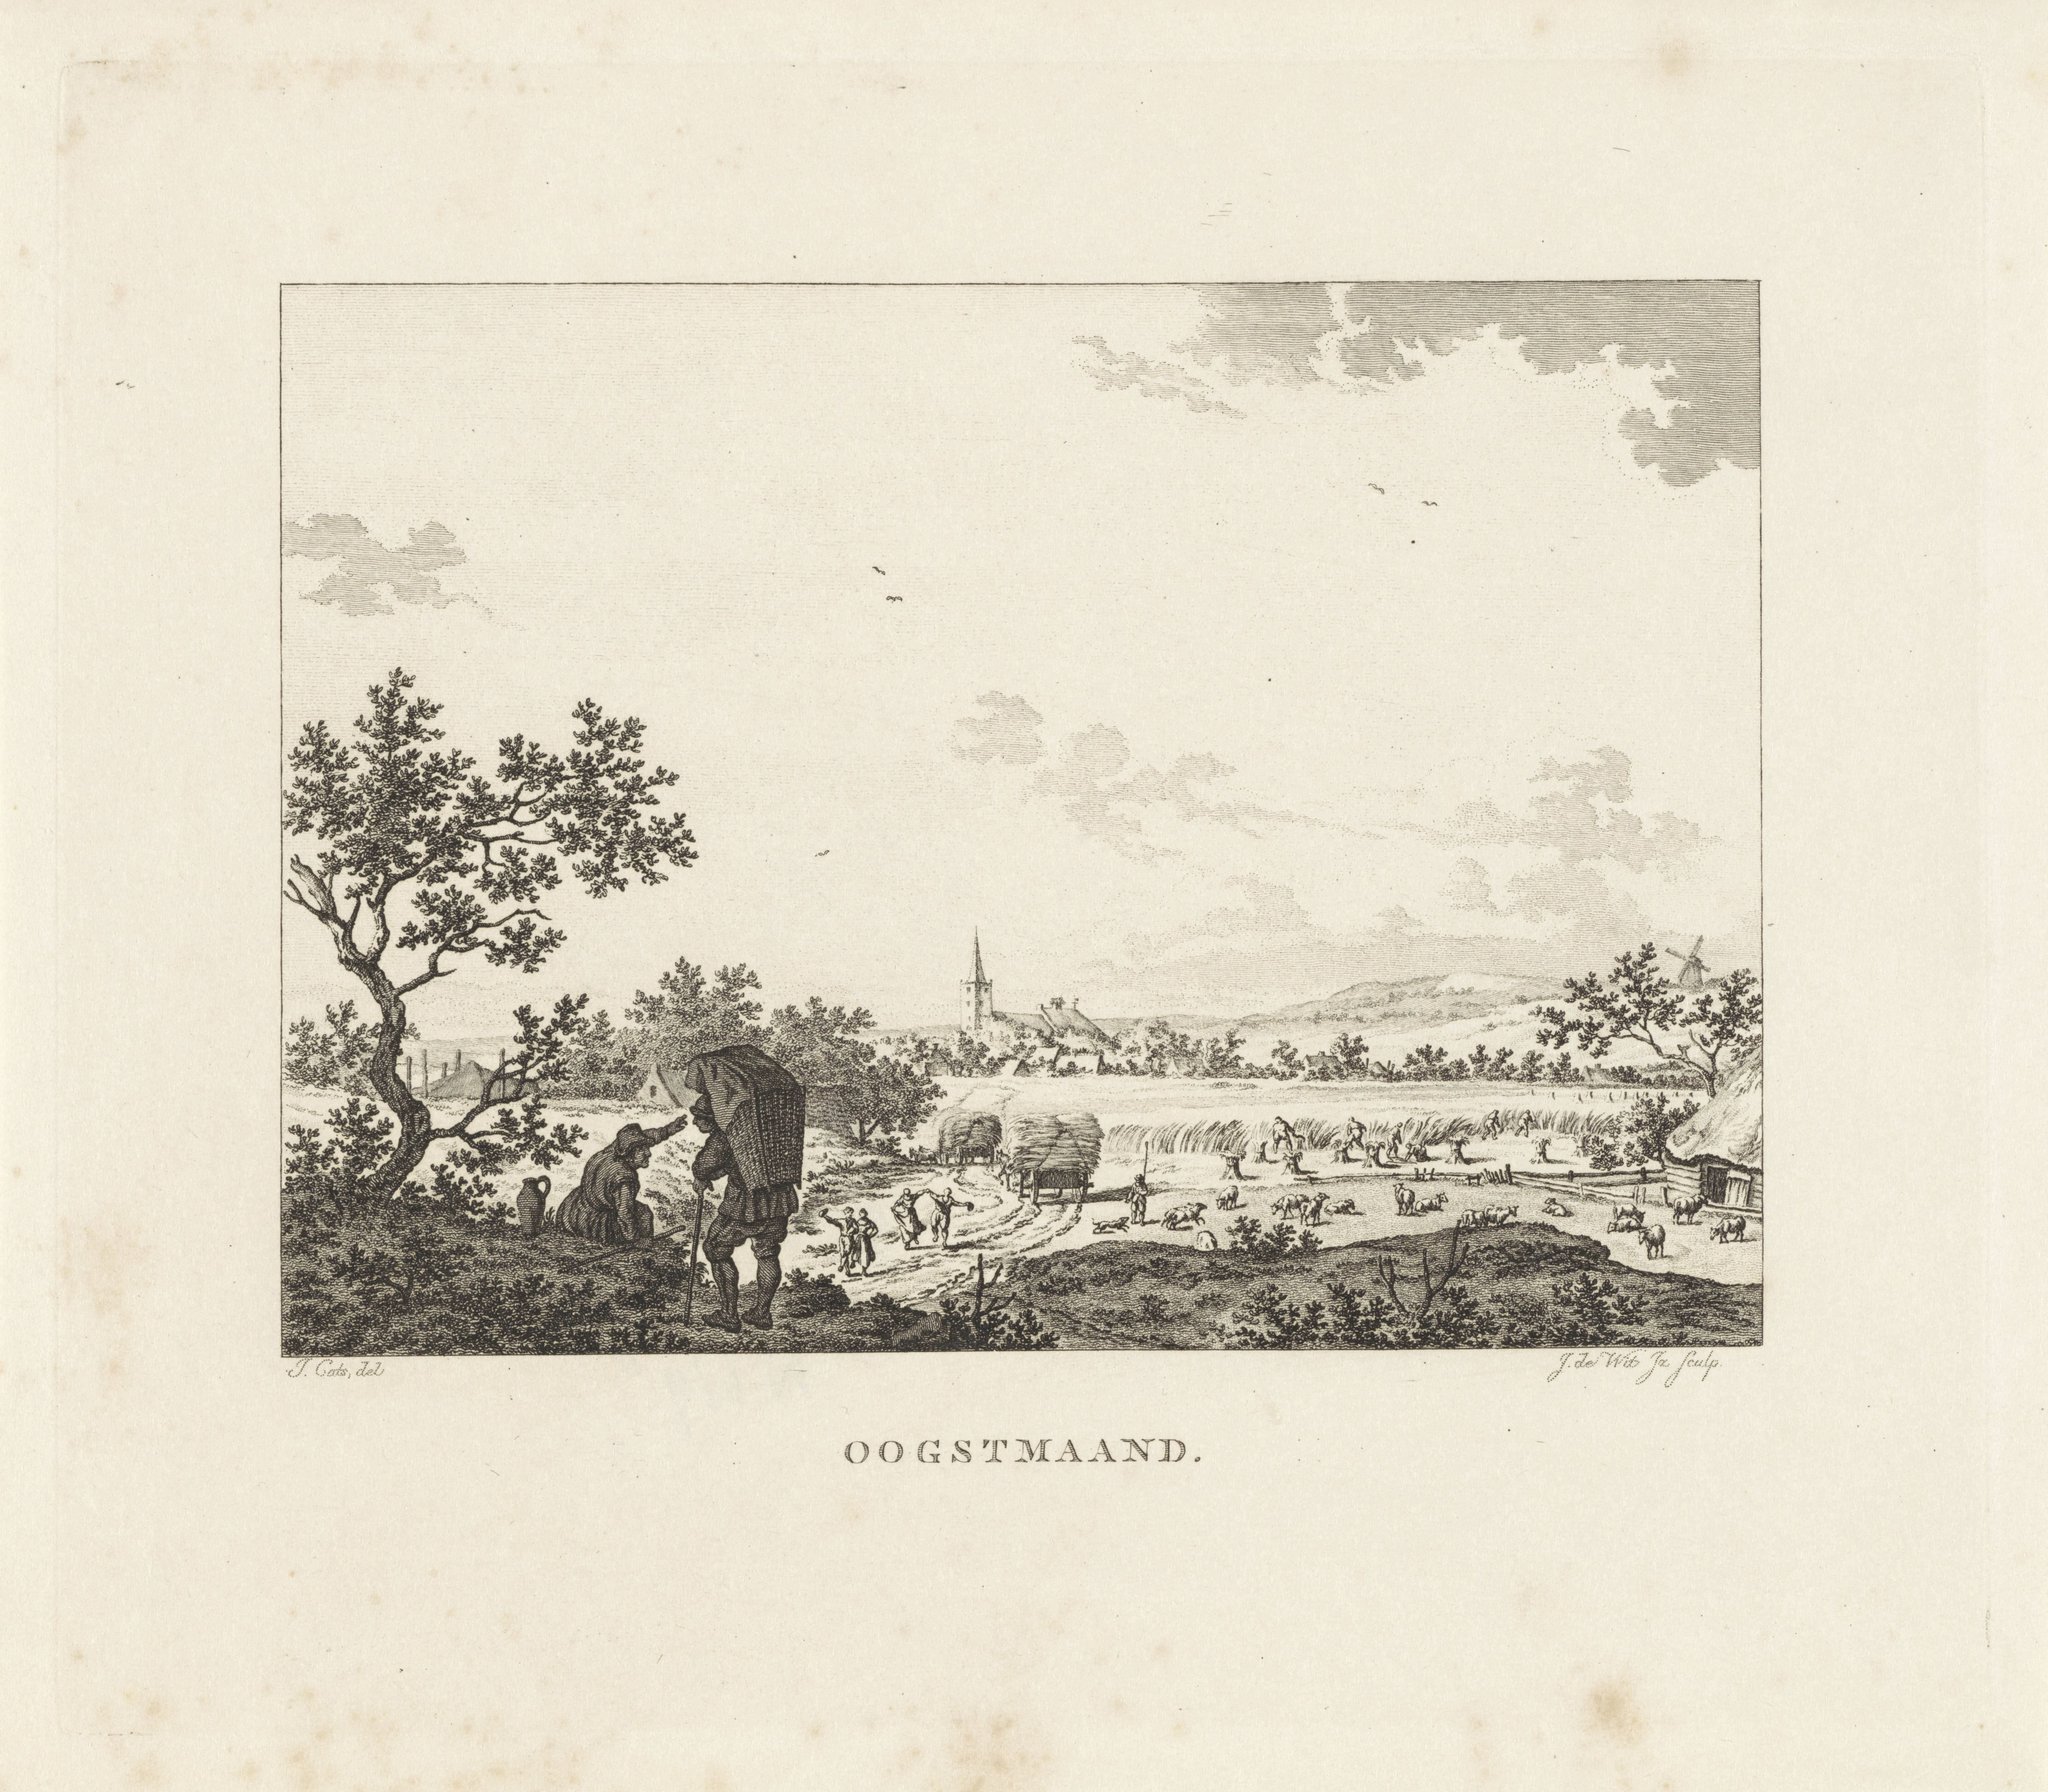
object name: print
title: De twaalf maanden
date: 1807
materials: paper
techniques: etching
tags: harvest festivities, august and its 'labours' (+ with scenes showing human occupations ~ seasons and months), pedlar, transporting ~ harvest, hay-wagon, reaping, picking, mowing ~ harvest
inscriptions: collector's mark: Lugt 2228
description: Een weids landschap met op de voorgrond een man met mand op de rug in gesprek met een zittende vrouw. In de verte wordt een korenveld gemaaid.